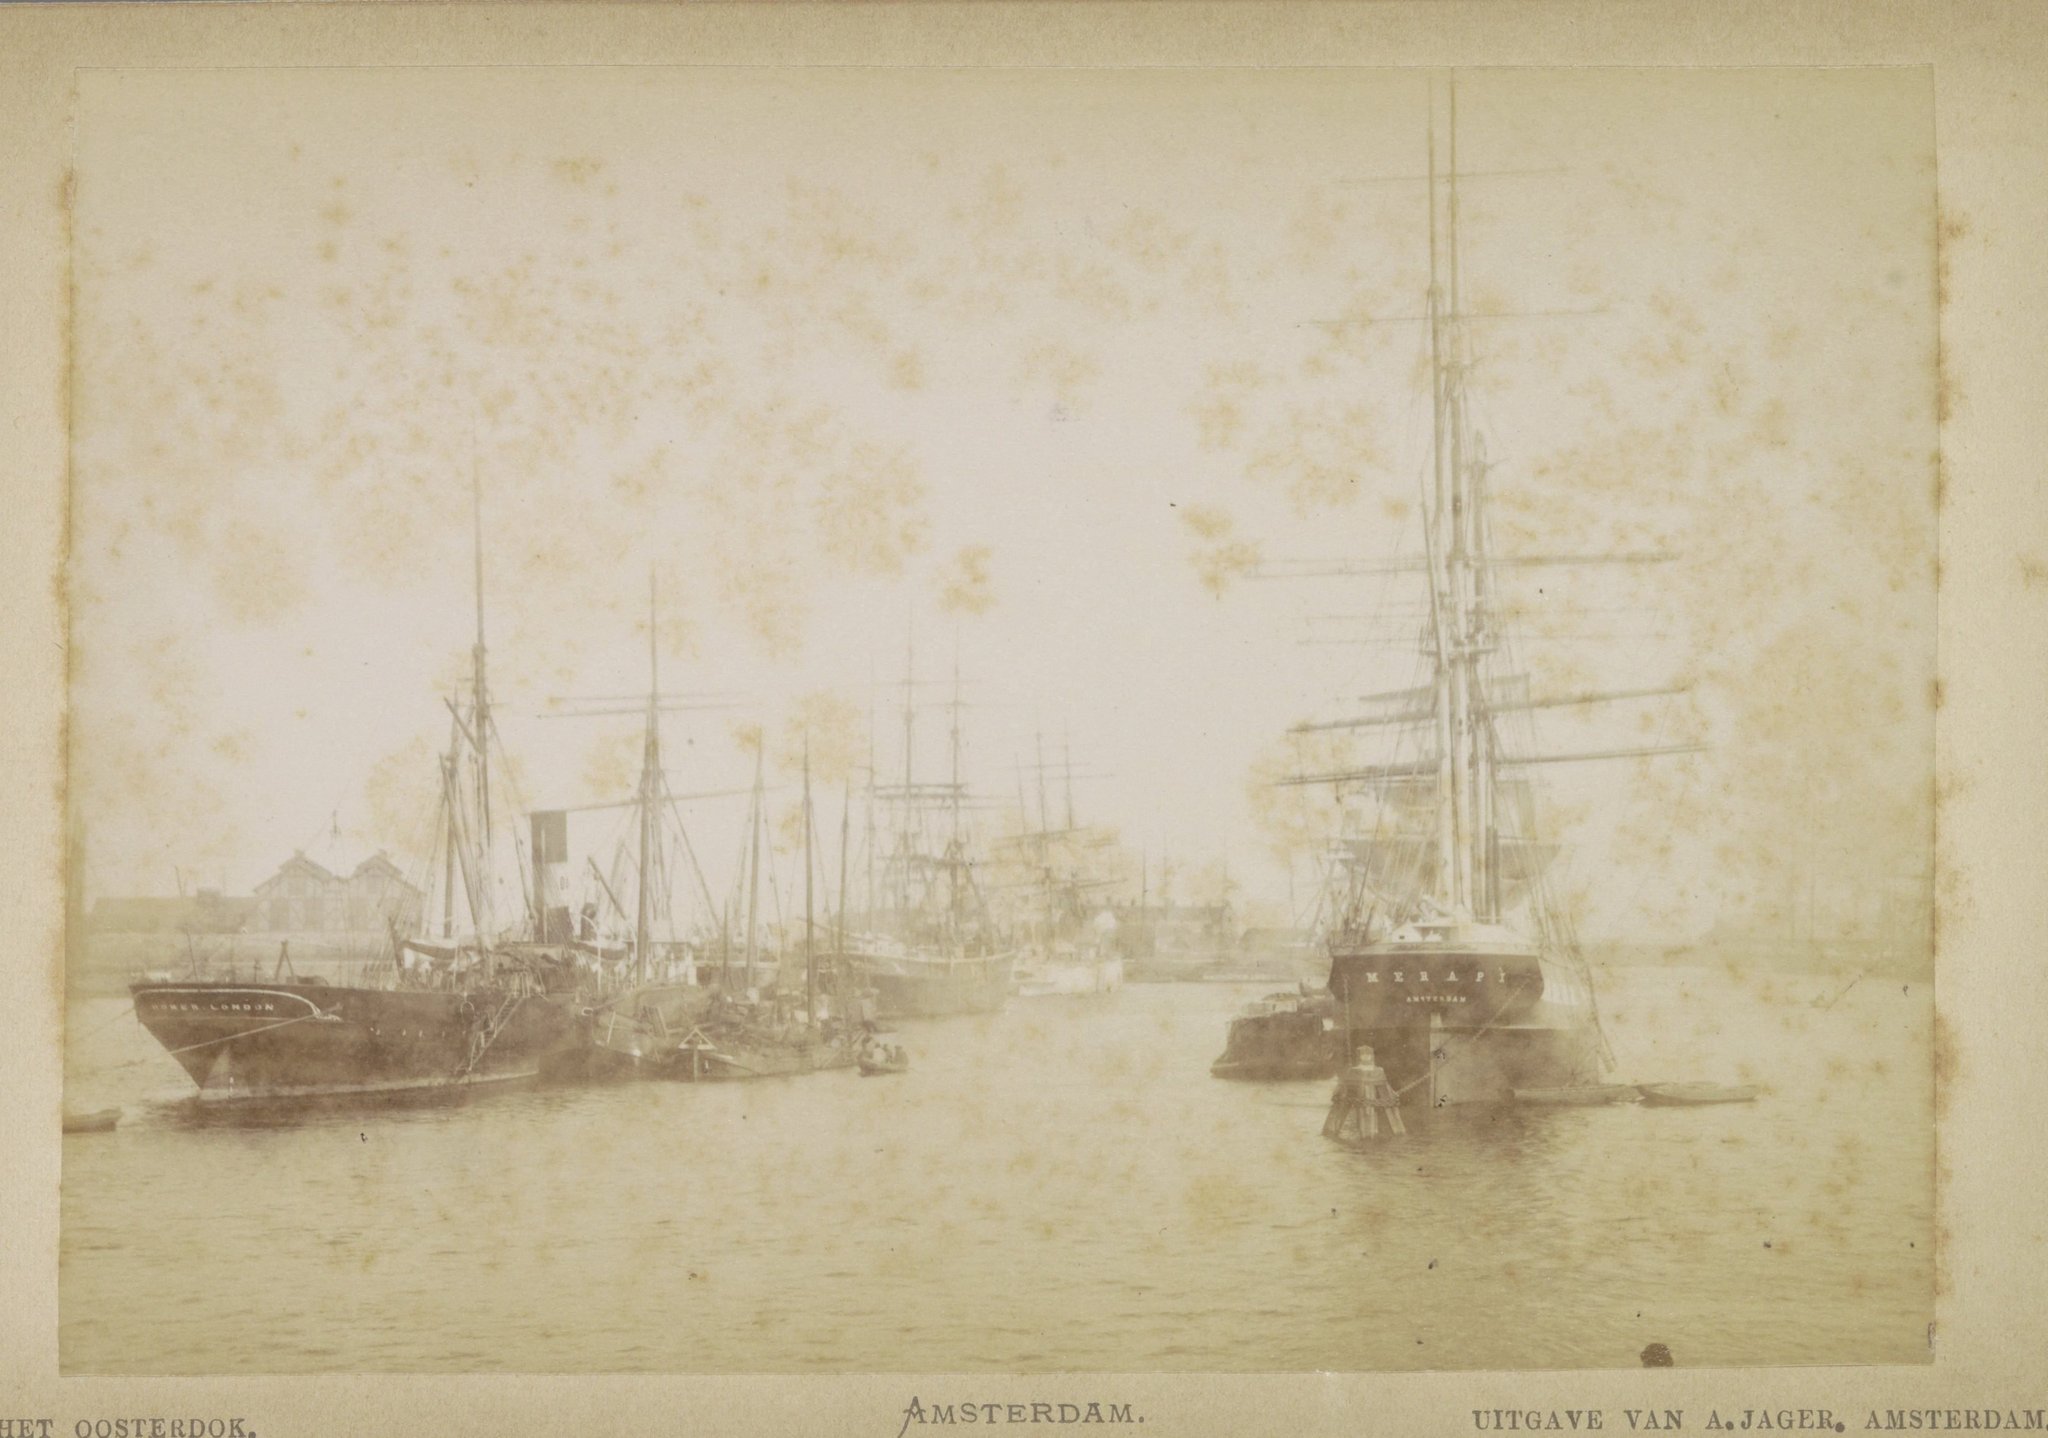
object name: cabinet photograph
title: Het Oosterdok. Amsterdam.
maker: andries jager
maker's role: publisher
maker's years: 1825-1905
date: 1860-1900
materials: cardboard, photographic support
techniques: albumen print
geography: amsterdam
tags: sailing-ship, sailing-boat, harbour (+ view ~ vehicle, ship, etc.)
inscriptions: name: ‘Scheltema & Holkema's Boekhandel Amsterdam’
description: Onderdeel van Leporelloalbum met 24 foto's van Amsterdam.